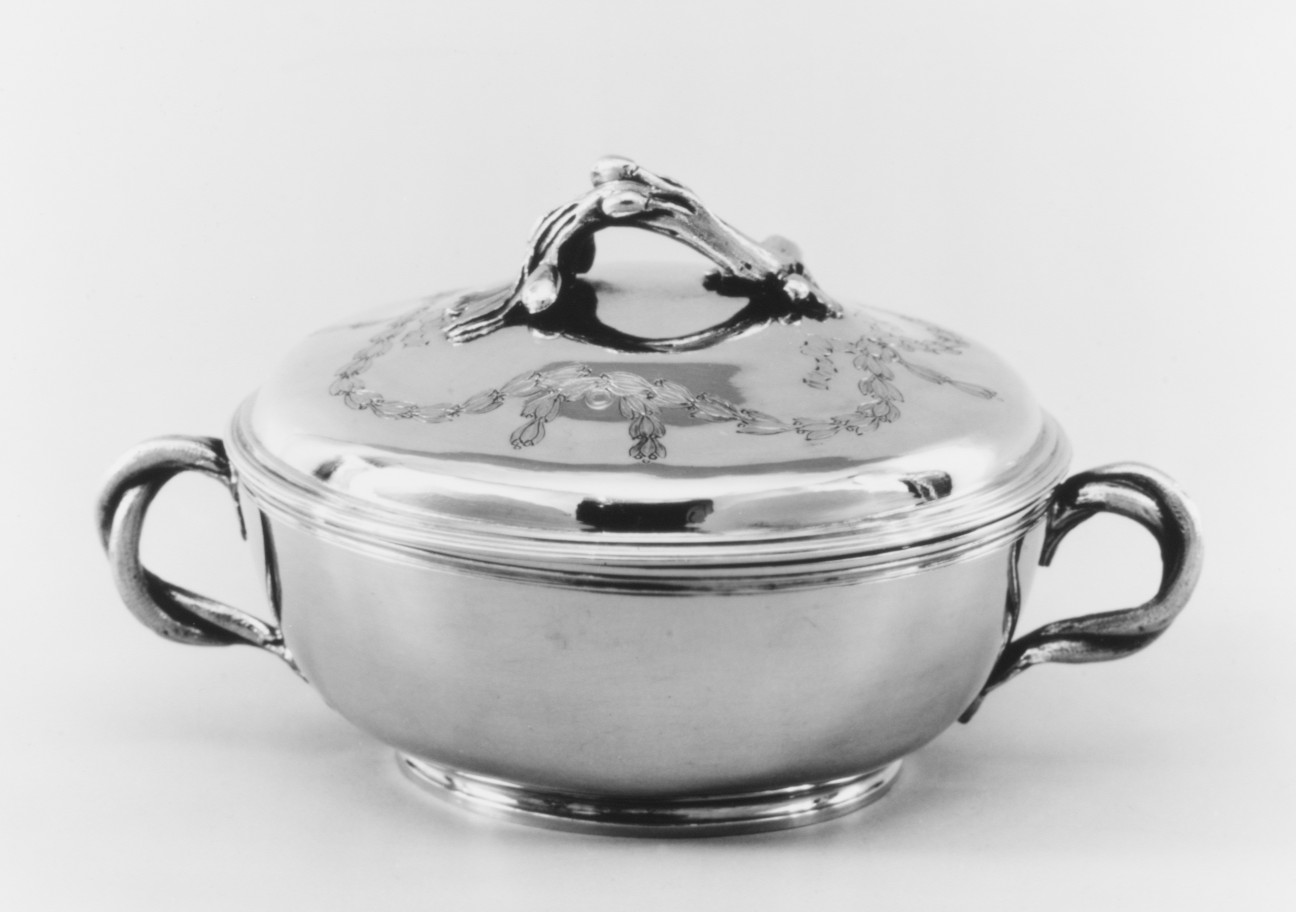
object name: bowl with cover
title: Bowl with cover (Écuelle)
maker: jacques-pierre marteau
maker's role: maker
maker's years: 1679-1779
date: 1769-1770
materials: silver gilt